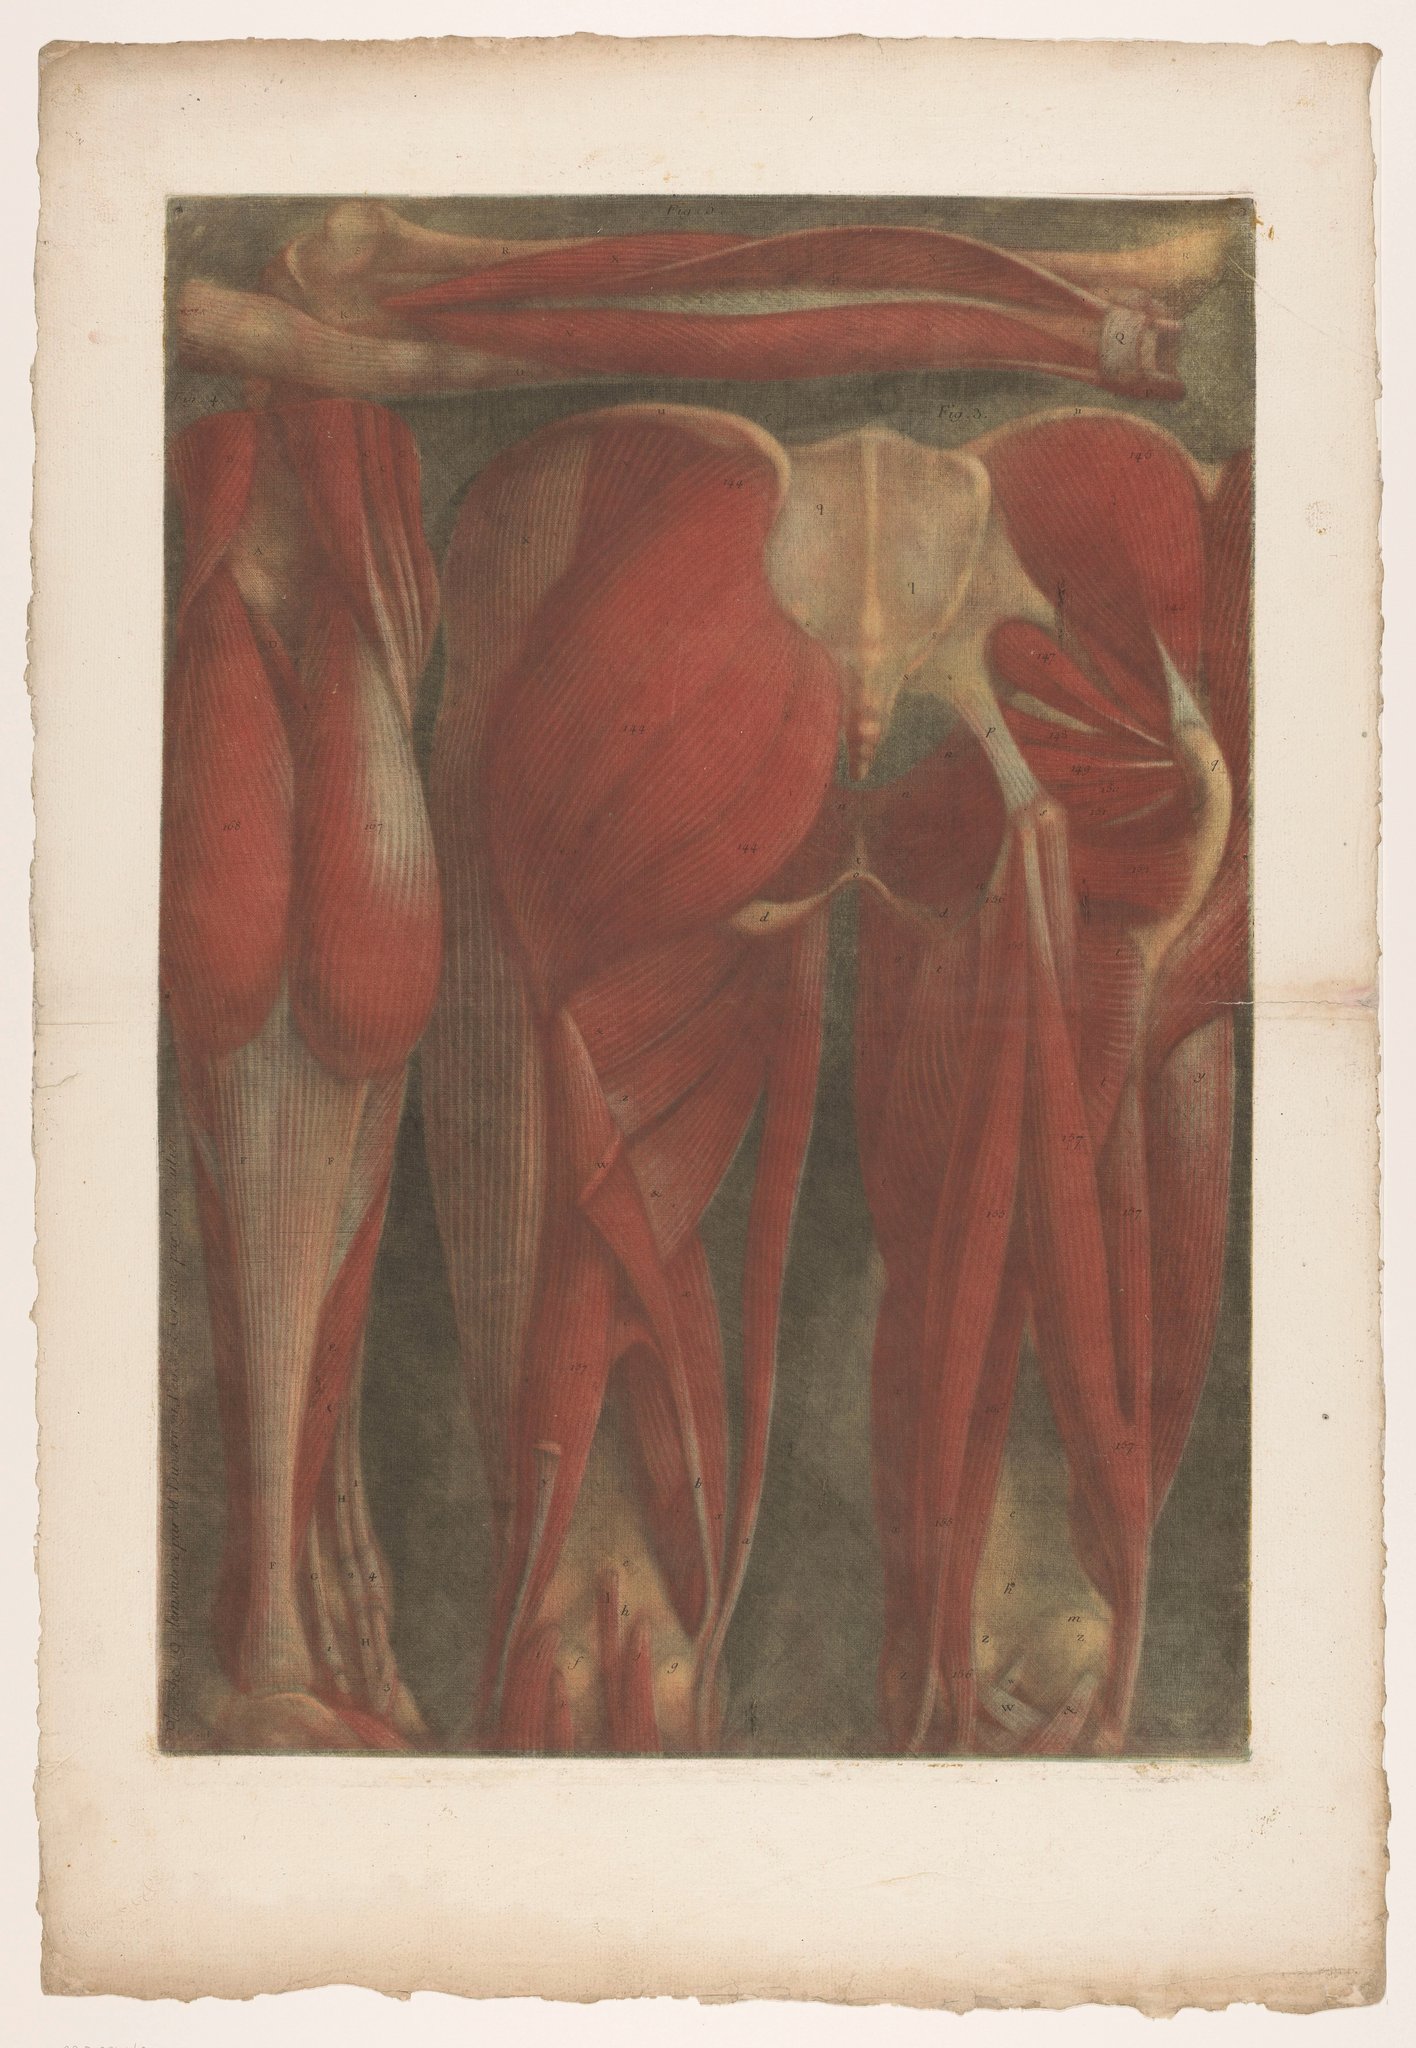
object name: print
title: Myologie complette en couleur et grandeur naturelle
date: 1746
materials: paper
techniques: engraving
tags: anatomical model of the muscles, muscle-man, 'écorché'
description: Prent gebruikt in: Gautier d'Agoty, Jacques Fabien. Myologie complette en couleur et grandeur naturelle (...). Parijs: Jacques Fabien Gautier d'Agoty e.a., 1746, plaat 19.